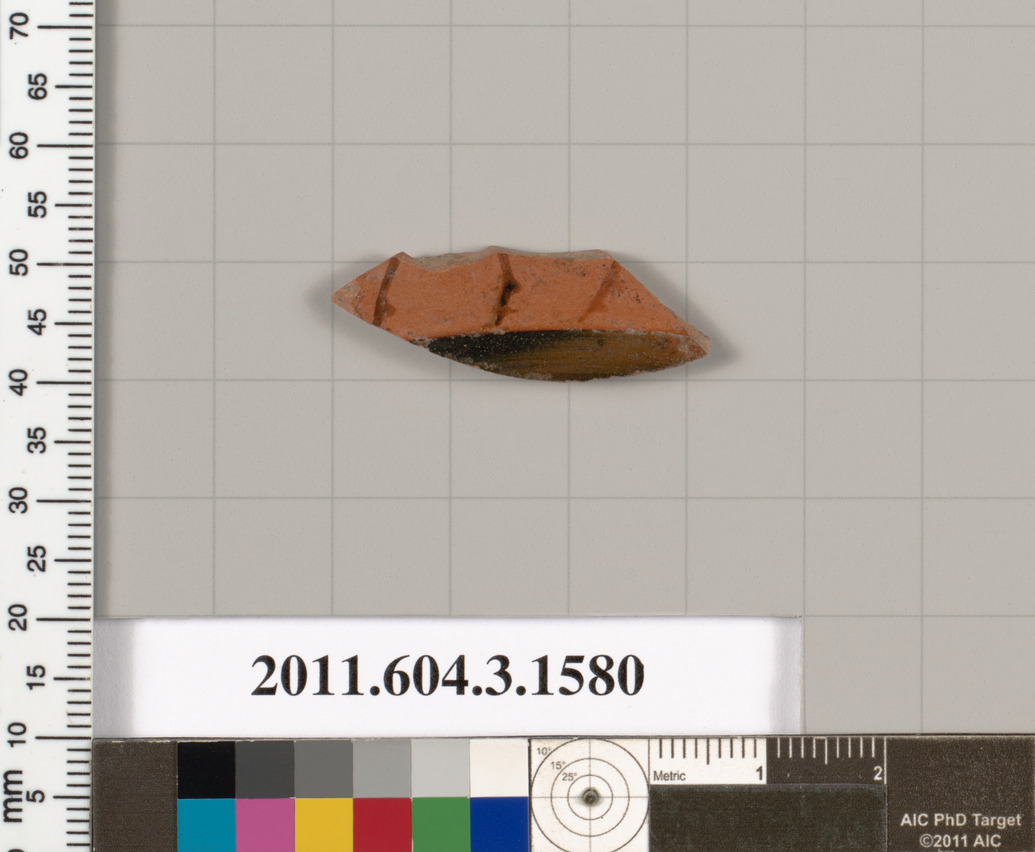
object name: kylix fragment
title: Terracotta fragment of a kylix: Band cup (drinking cup)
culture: greek, attic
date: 550-526 BCE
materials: terracotta